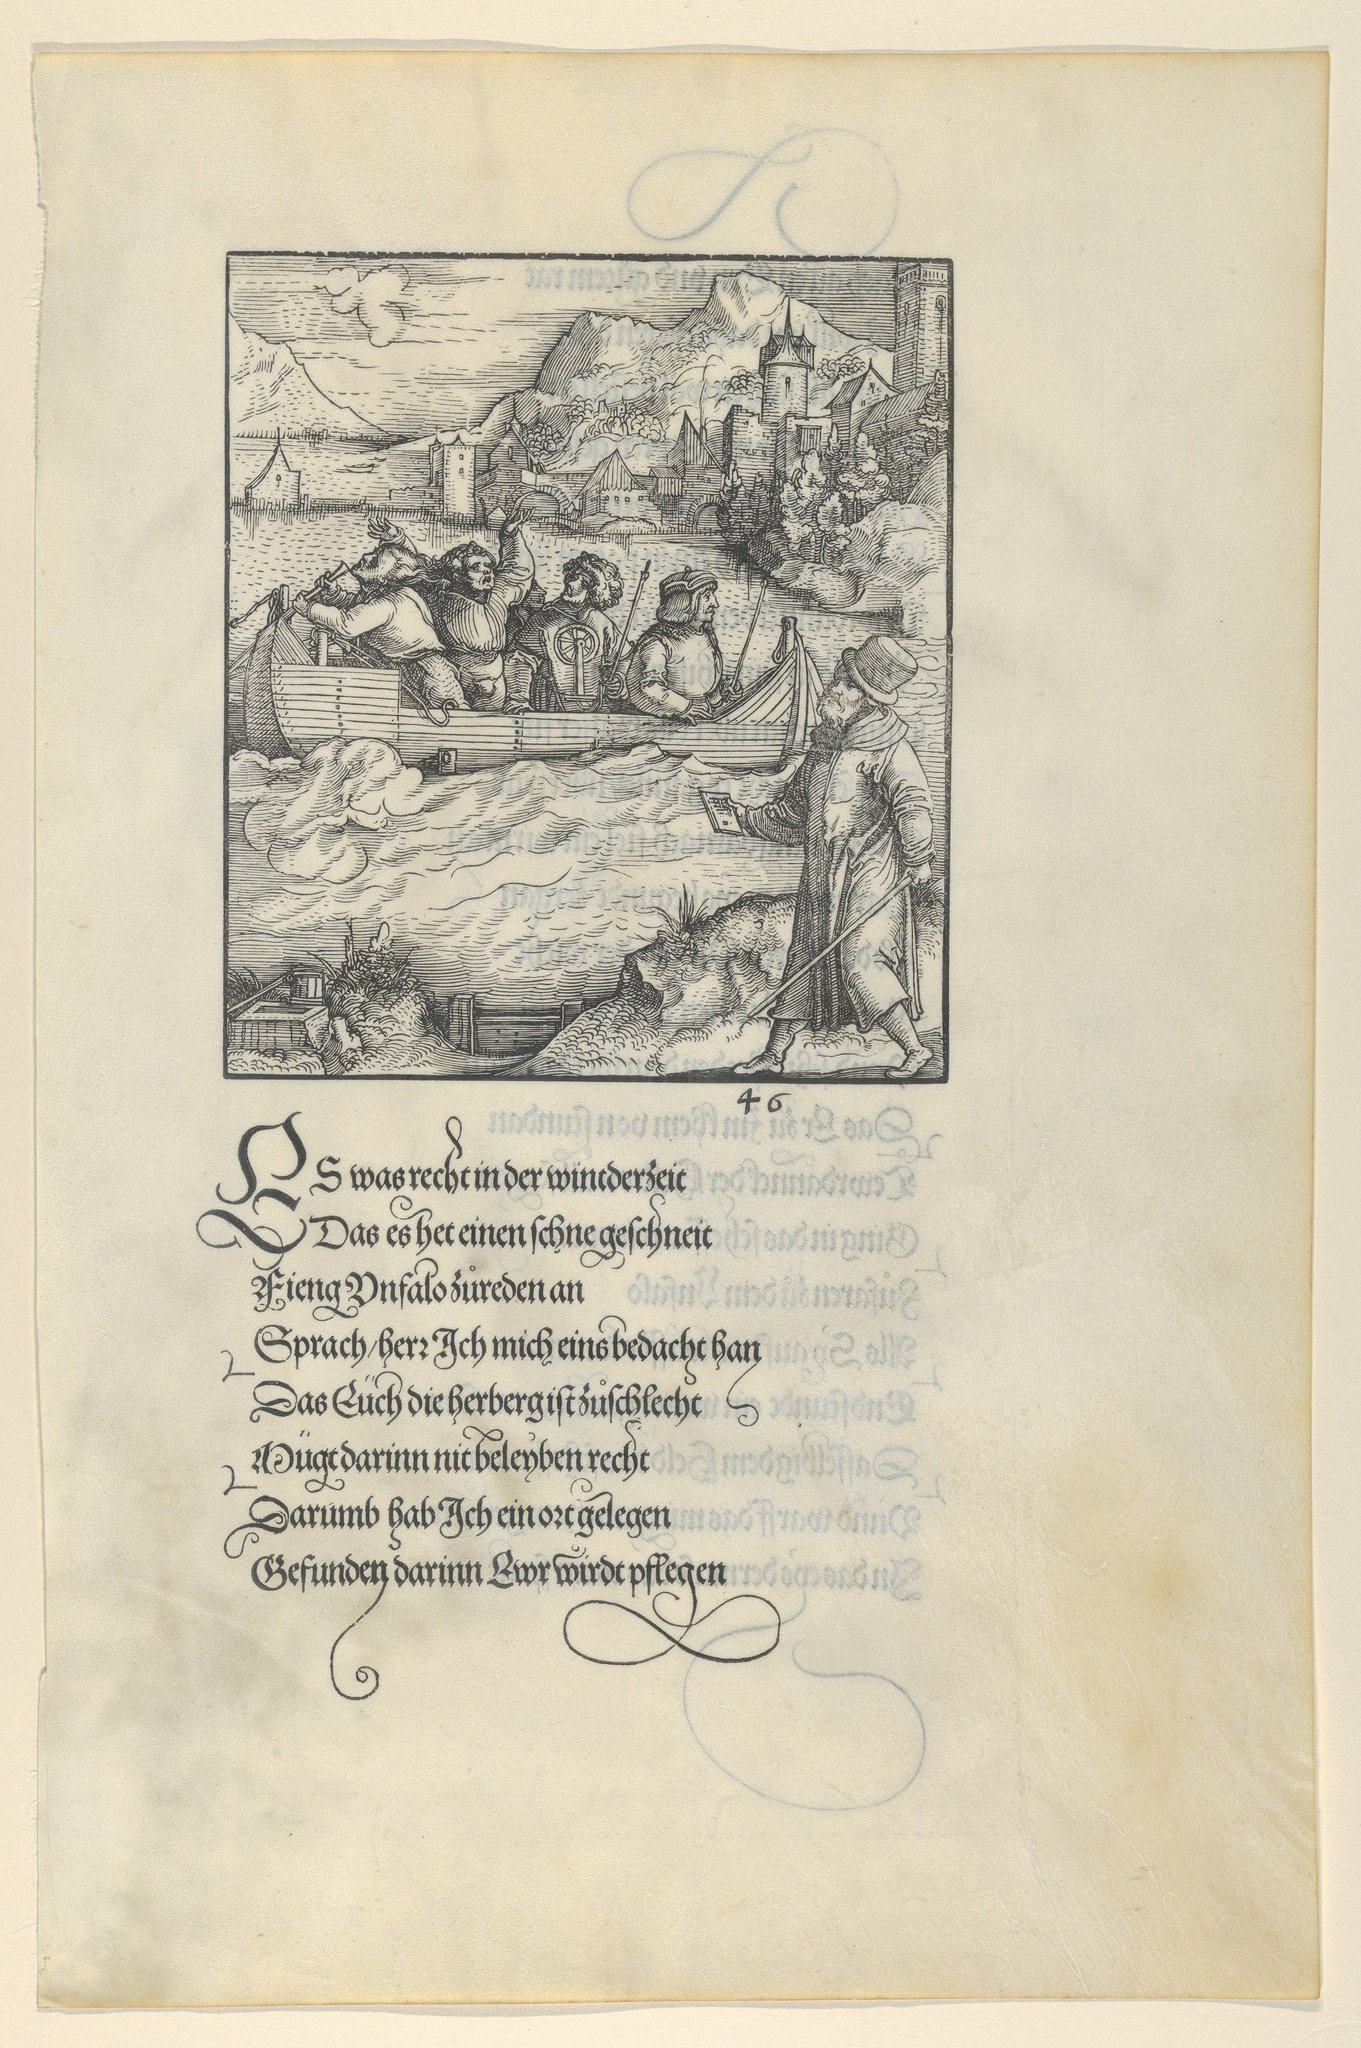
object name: print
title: Theuerdanck's Ship Caught in the Ice, from Theuerdanck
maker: hans schäufelein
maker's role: artist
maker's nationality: german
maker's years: 1480-1540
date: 1517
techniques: woodcut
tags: men,ice,ships